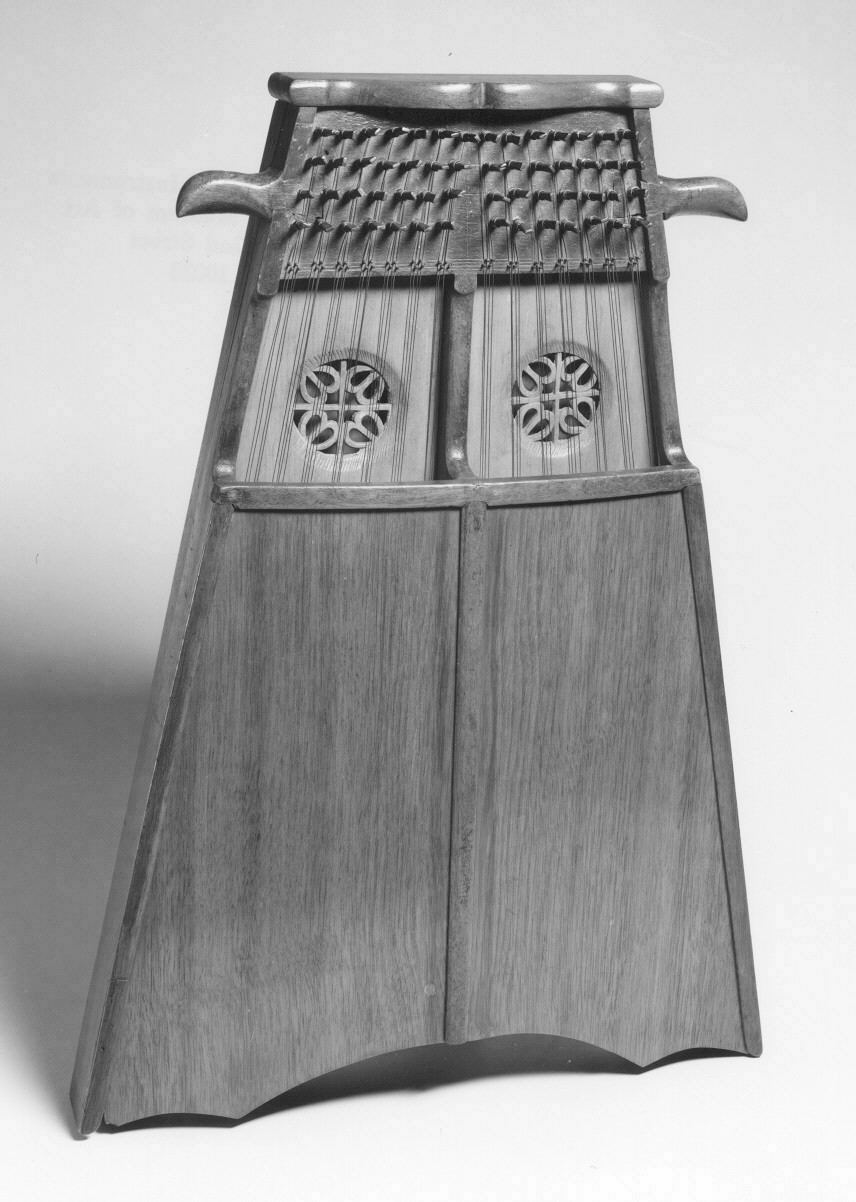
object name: bell harp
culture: british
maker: john simcock?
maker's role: maker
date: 1734-1766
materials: iron, wood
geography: england